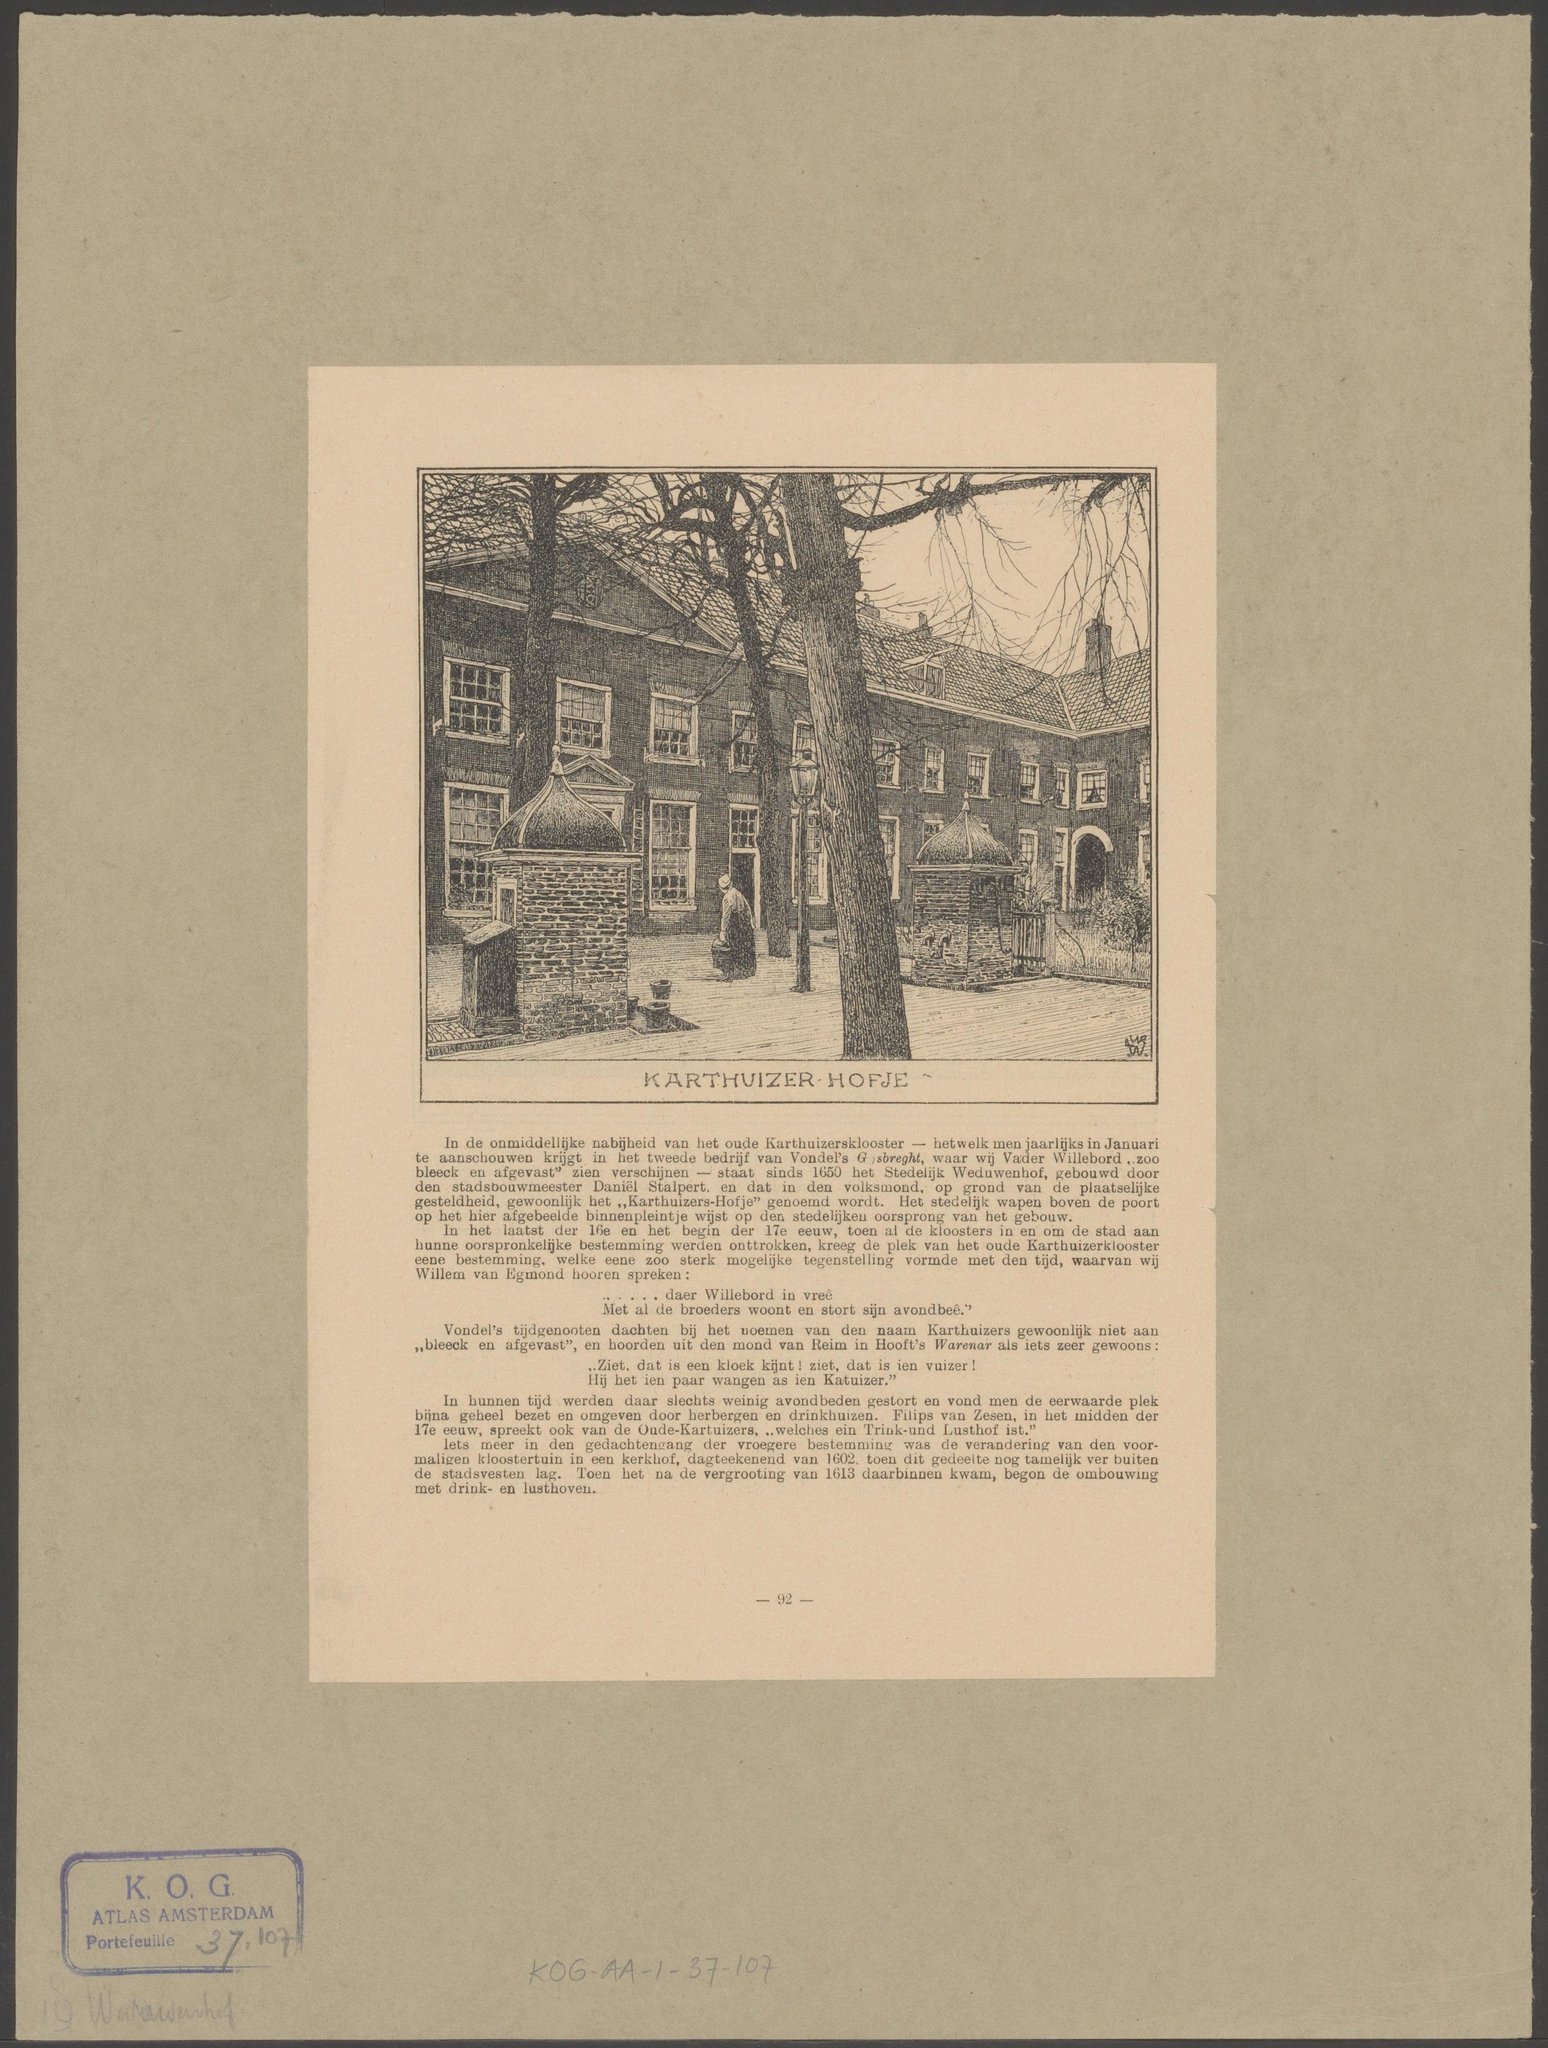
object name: book illustration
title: Gezicht op de binnenplaats van het Huiszittenweduwenhof (Kartuizerhof) te Amsterdam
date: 1907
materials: paper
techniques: letterpress printing, line block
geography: amsterdam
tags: poorhouse, courtyard, old-people's home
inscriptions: collector's mark: Lugt 1641b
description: Onderwerpsrubriek binnen de Atlas Amsterdam: Armwezen en liefdadige instellingen: I. Stadsinrichtingen: Stedelijk Armenhuis - Huiszittenhuizen - Huiszitten Weduwenhof.